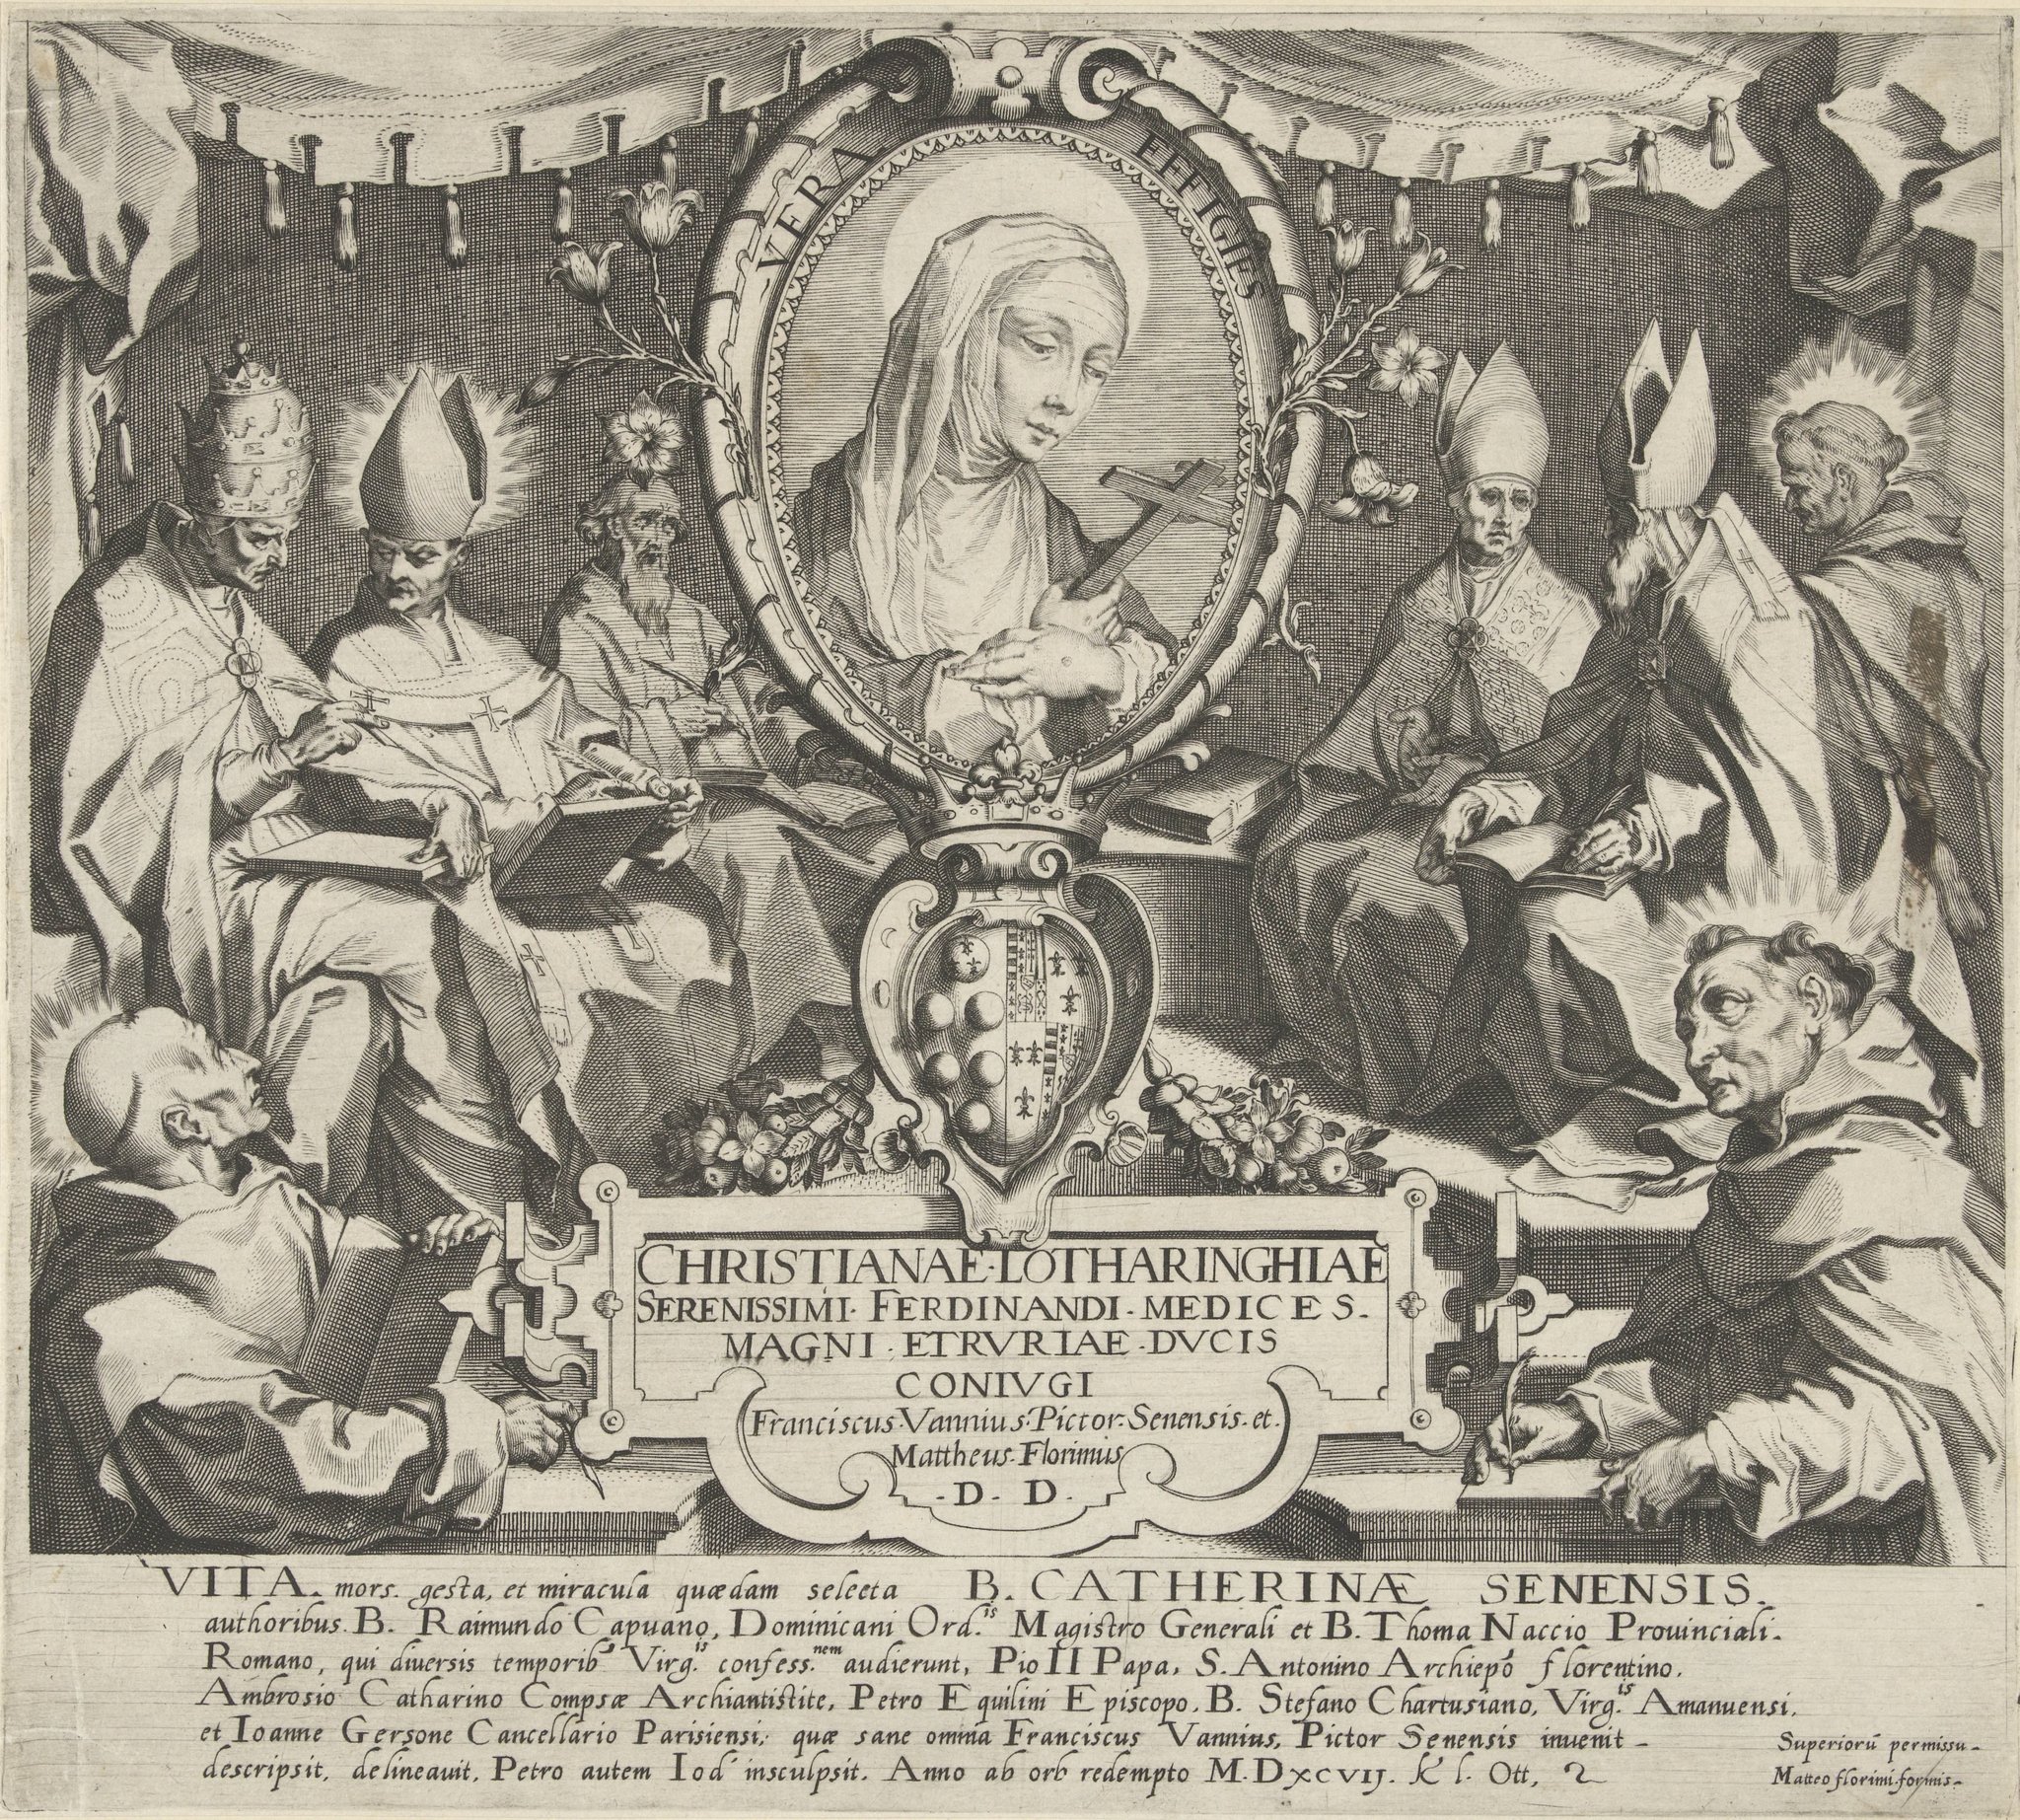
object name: print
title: Titelprent voor een serie met scènes uit het leven en wonderen van de Heilige Catharina van Siena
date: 1597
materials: paper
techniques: engraving, etching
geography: italy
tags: the virgin and dominican tertiary, catherine of siena; possible attributes: book, cross, crown of thorns, crucifix, demon under foot, heart (with cross), lily, plague-stricken, ring, rosary, stigmata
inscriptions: collector's mark: Lugt 240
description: Titelprent met diverse bisschoppen, allen schrijvend in een boek. In het midden een omlijsting met het busteportret van Catharina van Siena. Zij draagt een sluier en aanbidt een crucifix. In haar handen zijn de stigmata van Christus te zien. Onder de omlijsting een wapenschild met daaronder in een kader een verwijzing naar het huwelijk van Christine van Lotharingen en Ferdinando I de' Medici. In de marge een zesregelig onderschrift in het Latijn. Eerste prent uit een serie van twaalf met het leven en de wonderen van de H. Catharina van Siena.